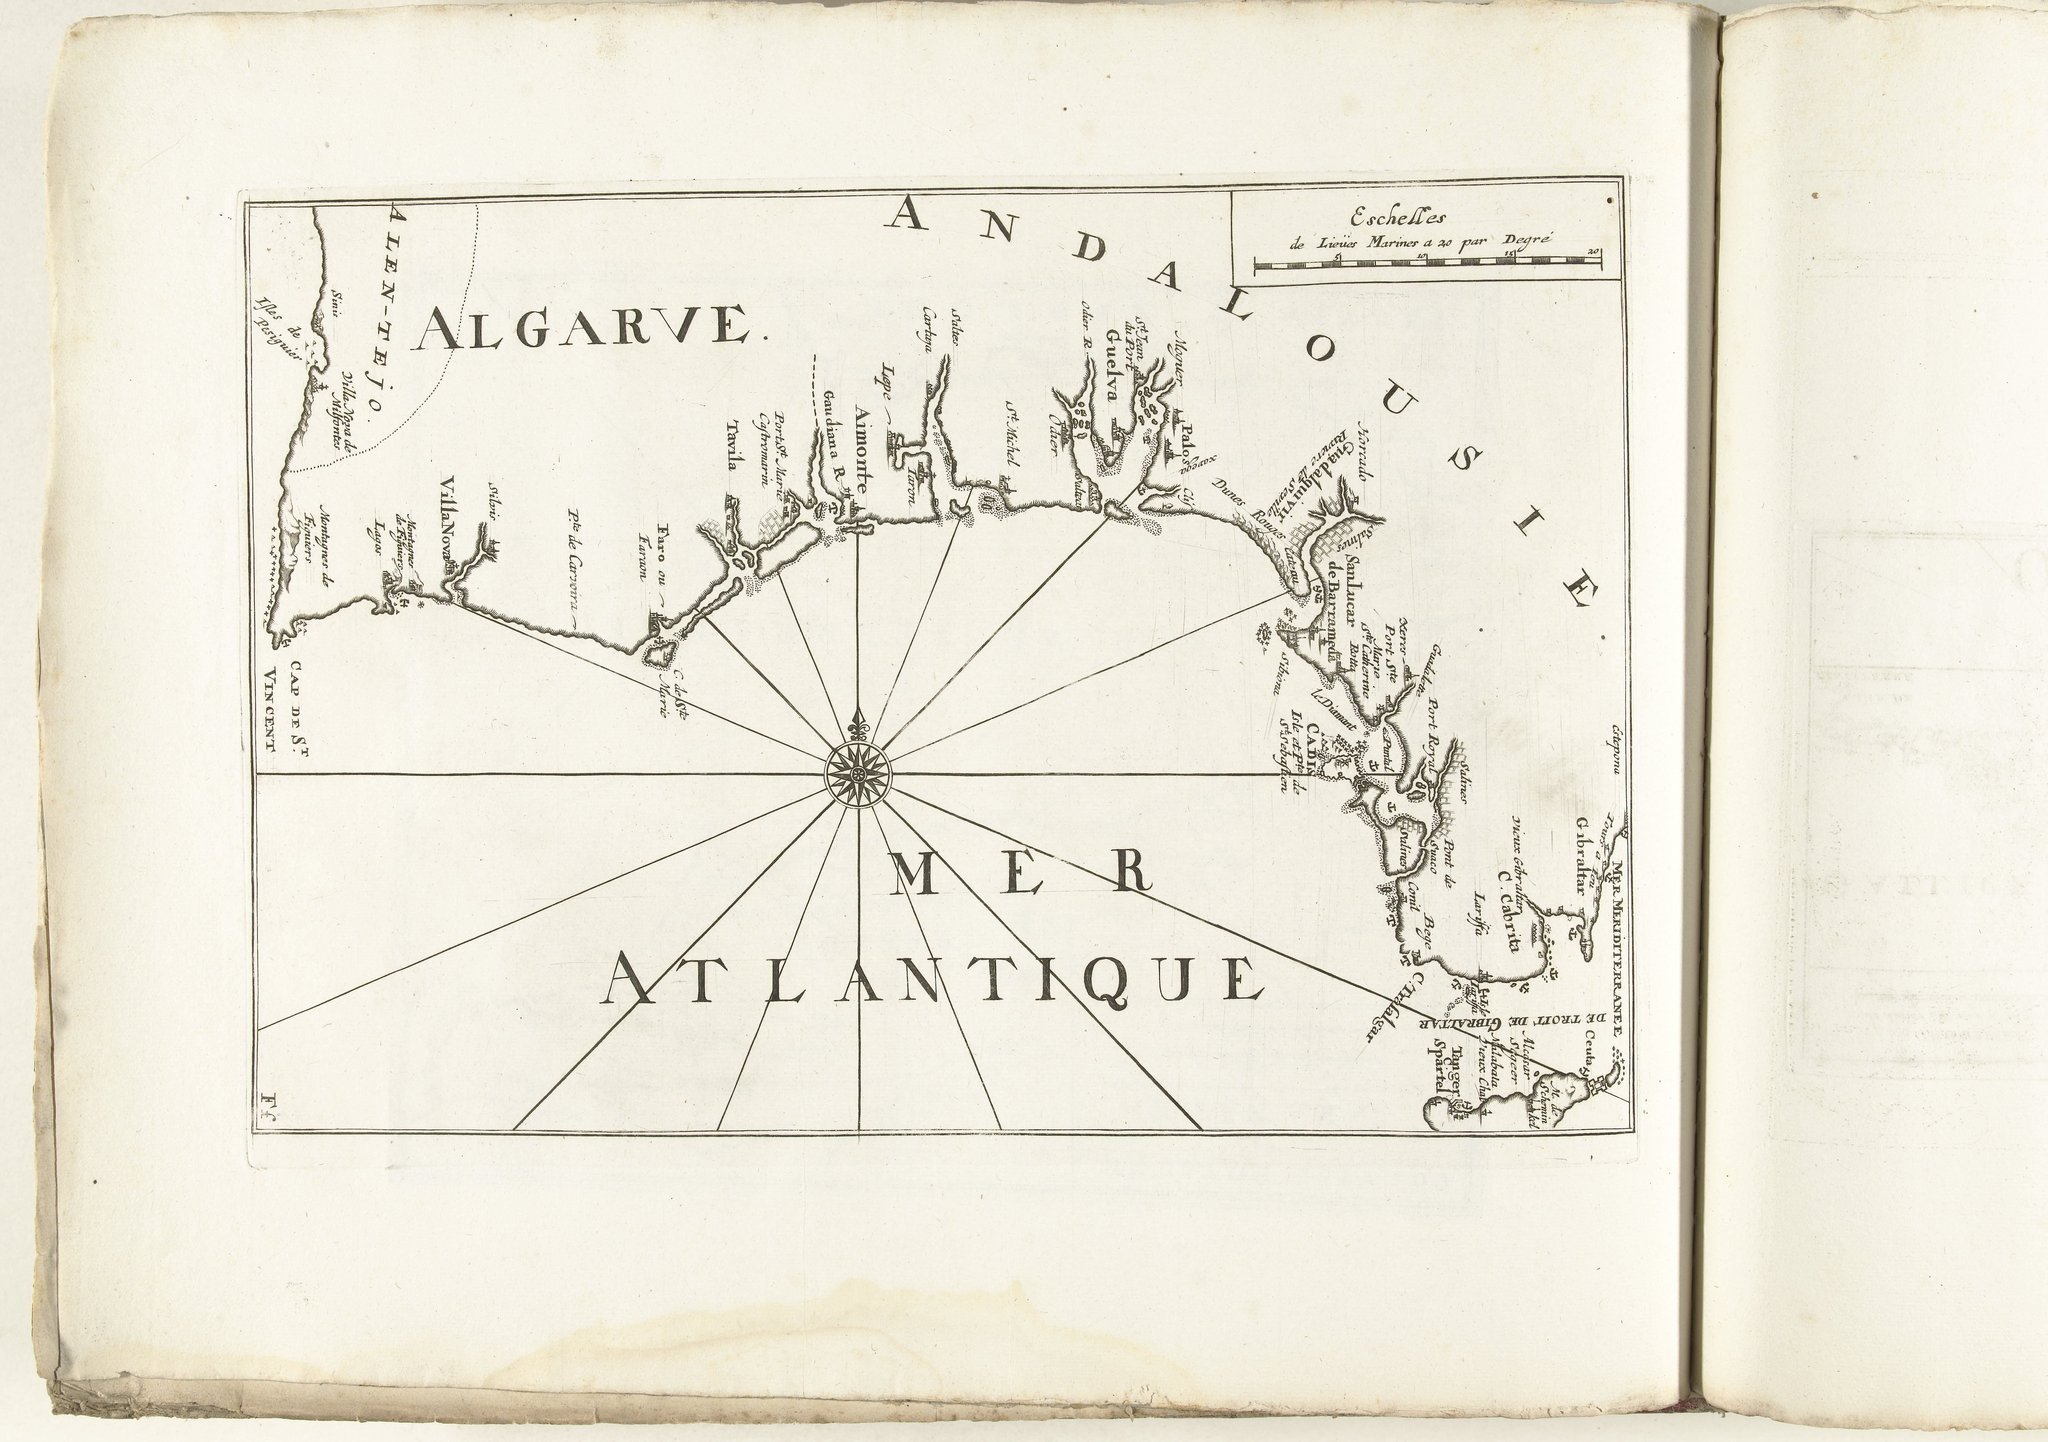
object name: map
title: Les Forces de l'Europe, Asie, Afrique et Amerique, ou description des principales villes avec leurs fortifications. Dessignées par les meilleurs ingenieurs, particulierement celles qui sont sous la domination de la France (...) et ornées de plusieurs superbes edifices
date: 1702-1703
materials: paper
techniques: engraving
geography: northern netherlands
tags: maps of separate countries or regions, spain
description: Kaart van de zuidkust van Portugal en Spanje van de Algarve tot aan Gibraltar. Gemerkt rechtsonder: Ff. Onderdeel van het tweede van twee delen van het prentwerk: Les costes de France et d'Espagne (oftewel deel 14 van: Les Forces de l'Europe, Asie, Afrique et Amerique), uitgegeven ca. 1702. Het prentwerk bestaat in totaal uit 43 gemerkte platen van de kust van Frankrijk en Spanje, in het kader van de Spaanse Successieoorlog. Deze platen zijn gekopieerd naar anonieme Franse platen oorspronkelijk uitgegeven door Nicolas de Fer te Parijs. Titel en opschriften in de plaat in het Frans.